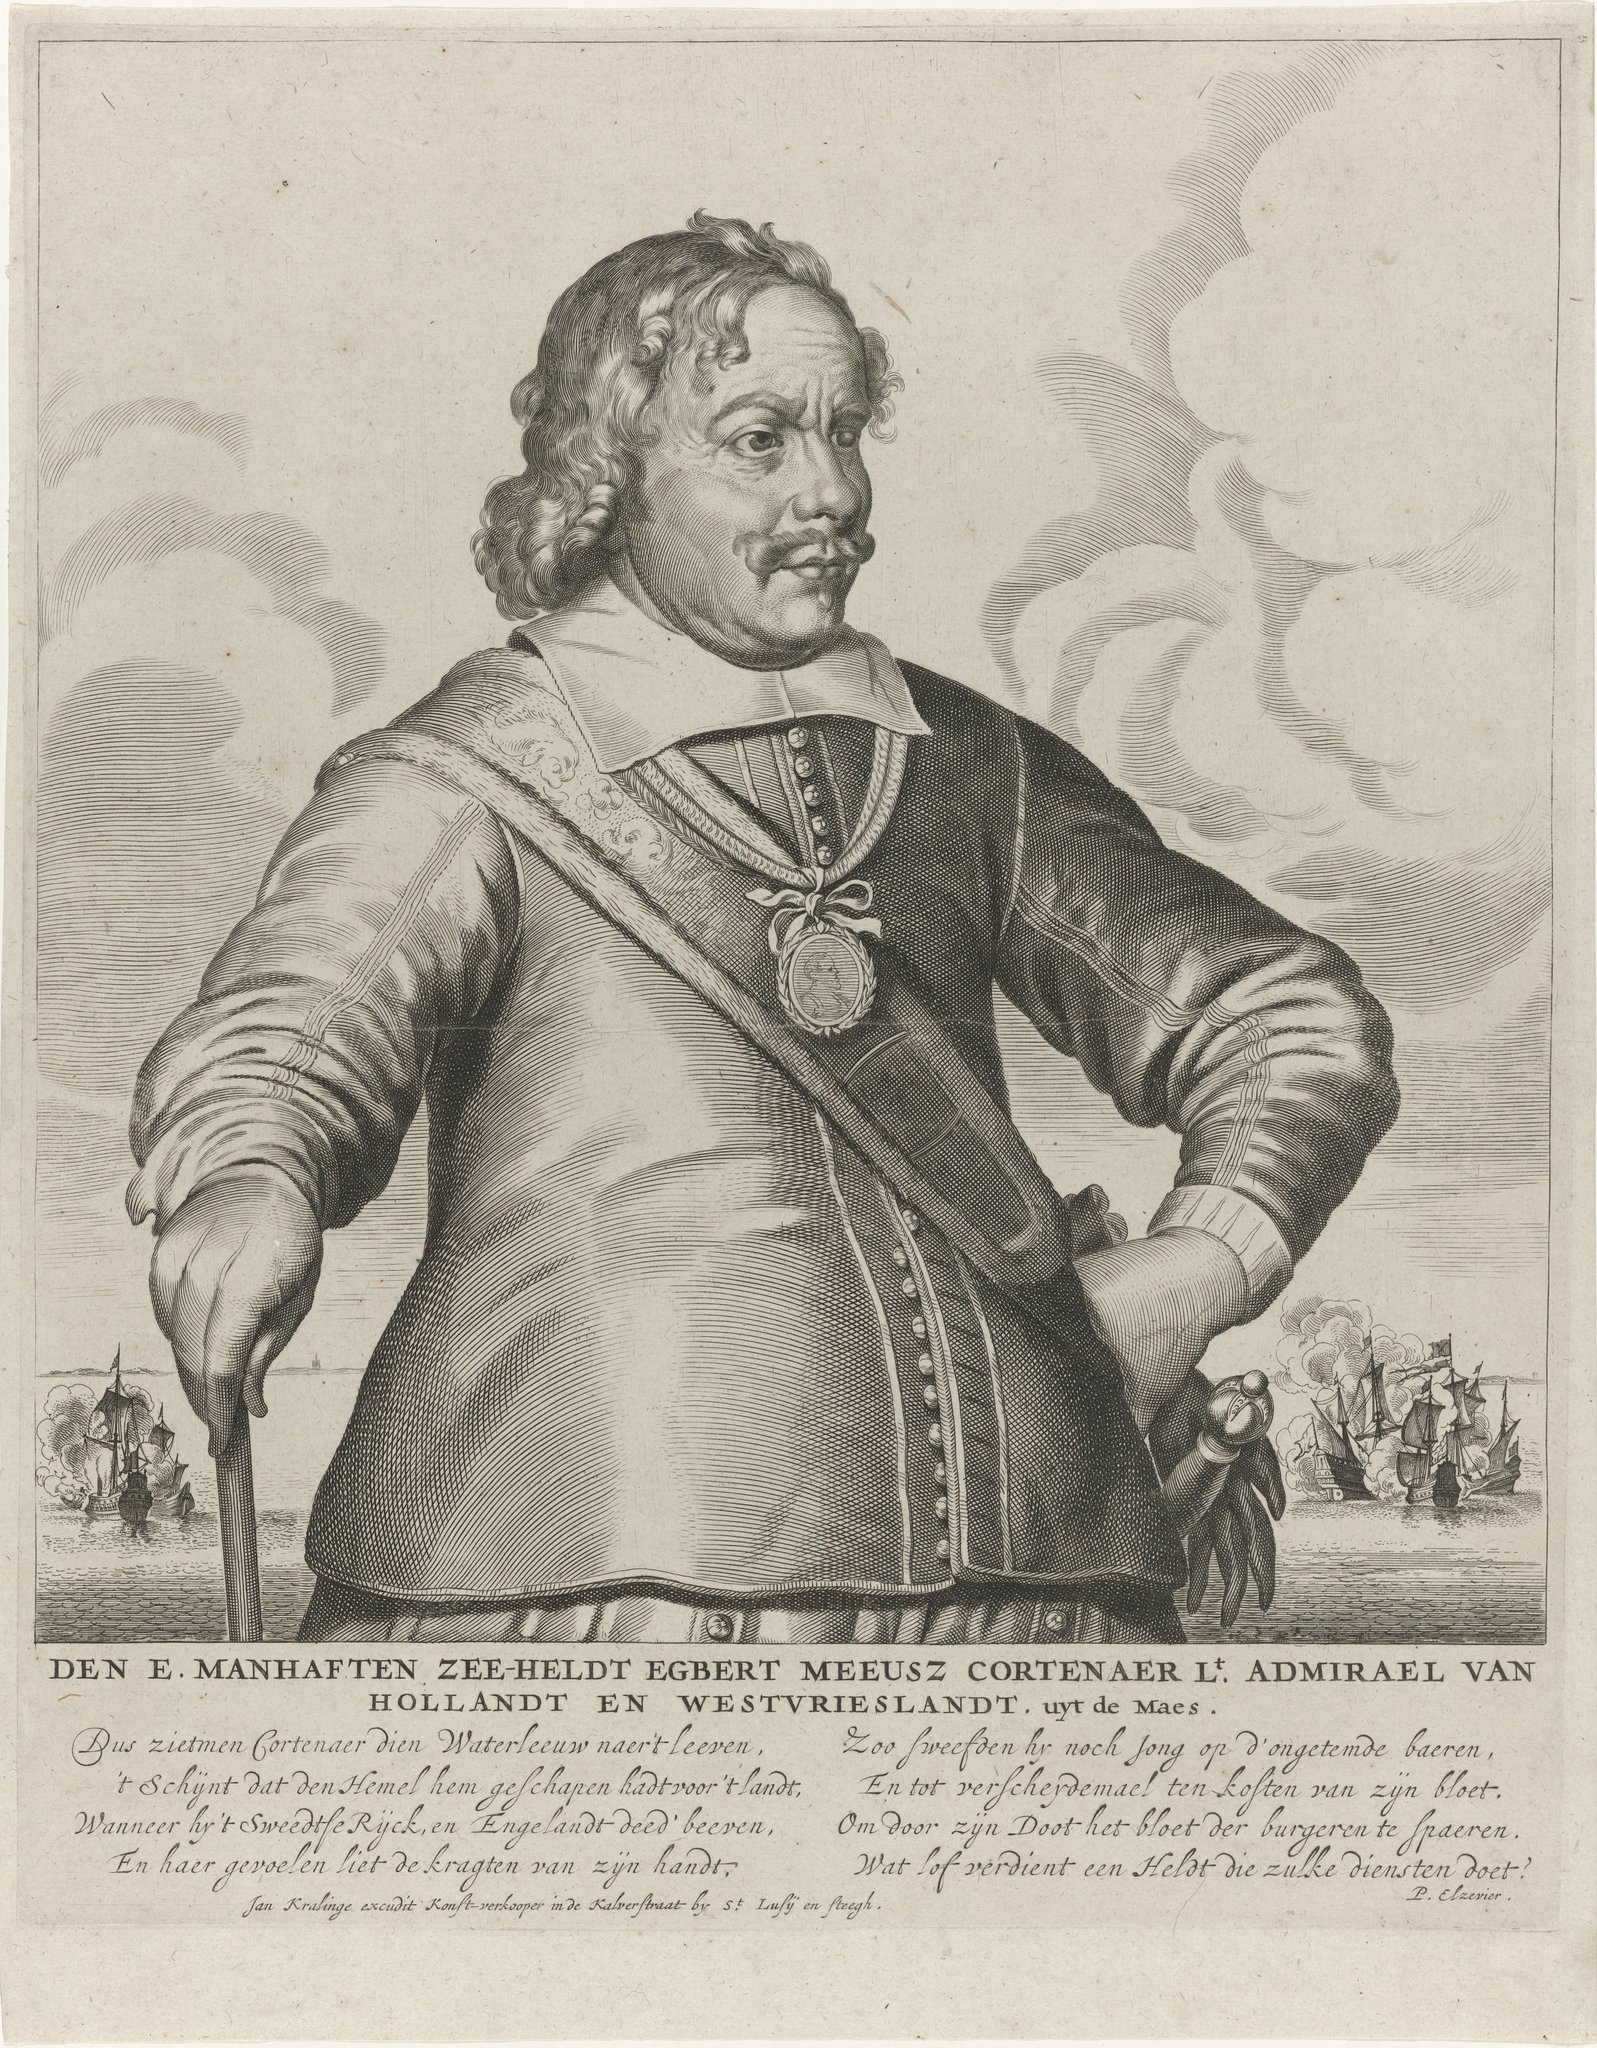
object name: print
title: Portret van Egbert Meeusz Kortenaer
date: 1665-1667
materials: paper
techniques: engraving, etching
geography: amsterdam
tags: admiraal, egbert meeusz kortenaar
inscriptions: collector's mark: Lugt 240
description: Portret van admiraal Egbert Meeusz Kortenaer met een penning om zijn hals. Op de achtergrond een zeeslag. Onderaan twee vierregelige verzen over zijn heldendaden in het Nederlands.